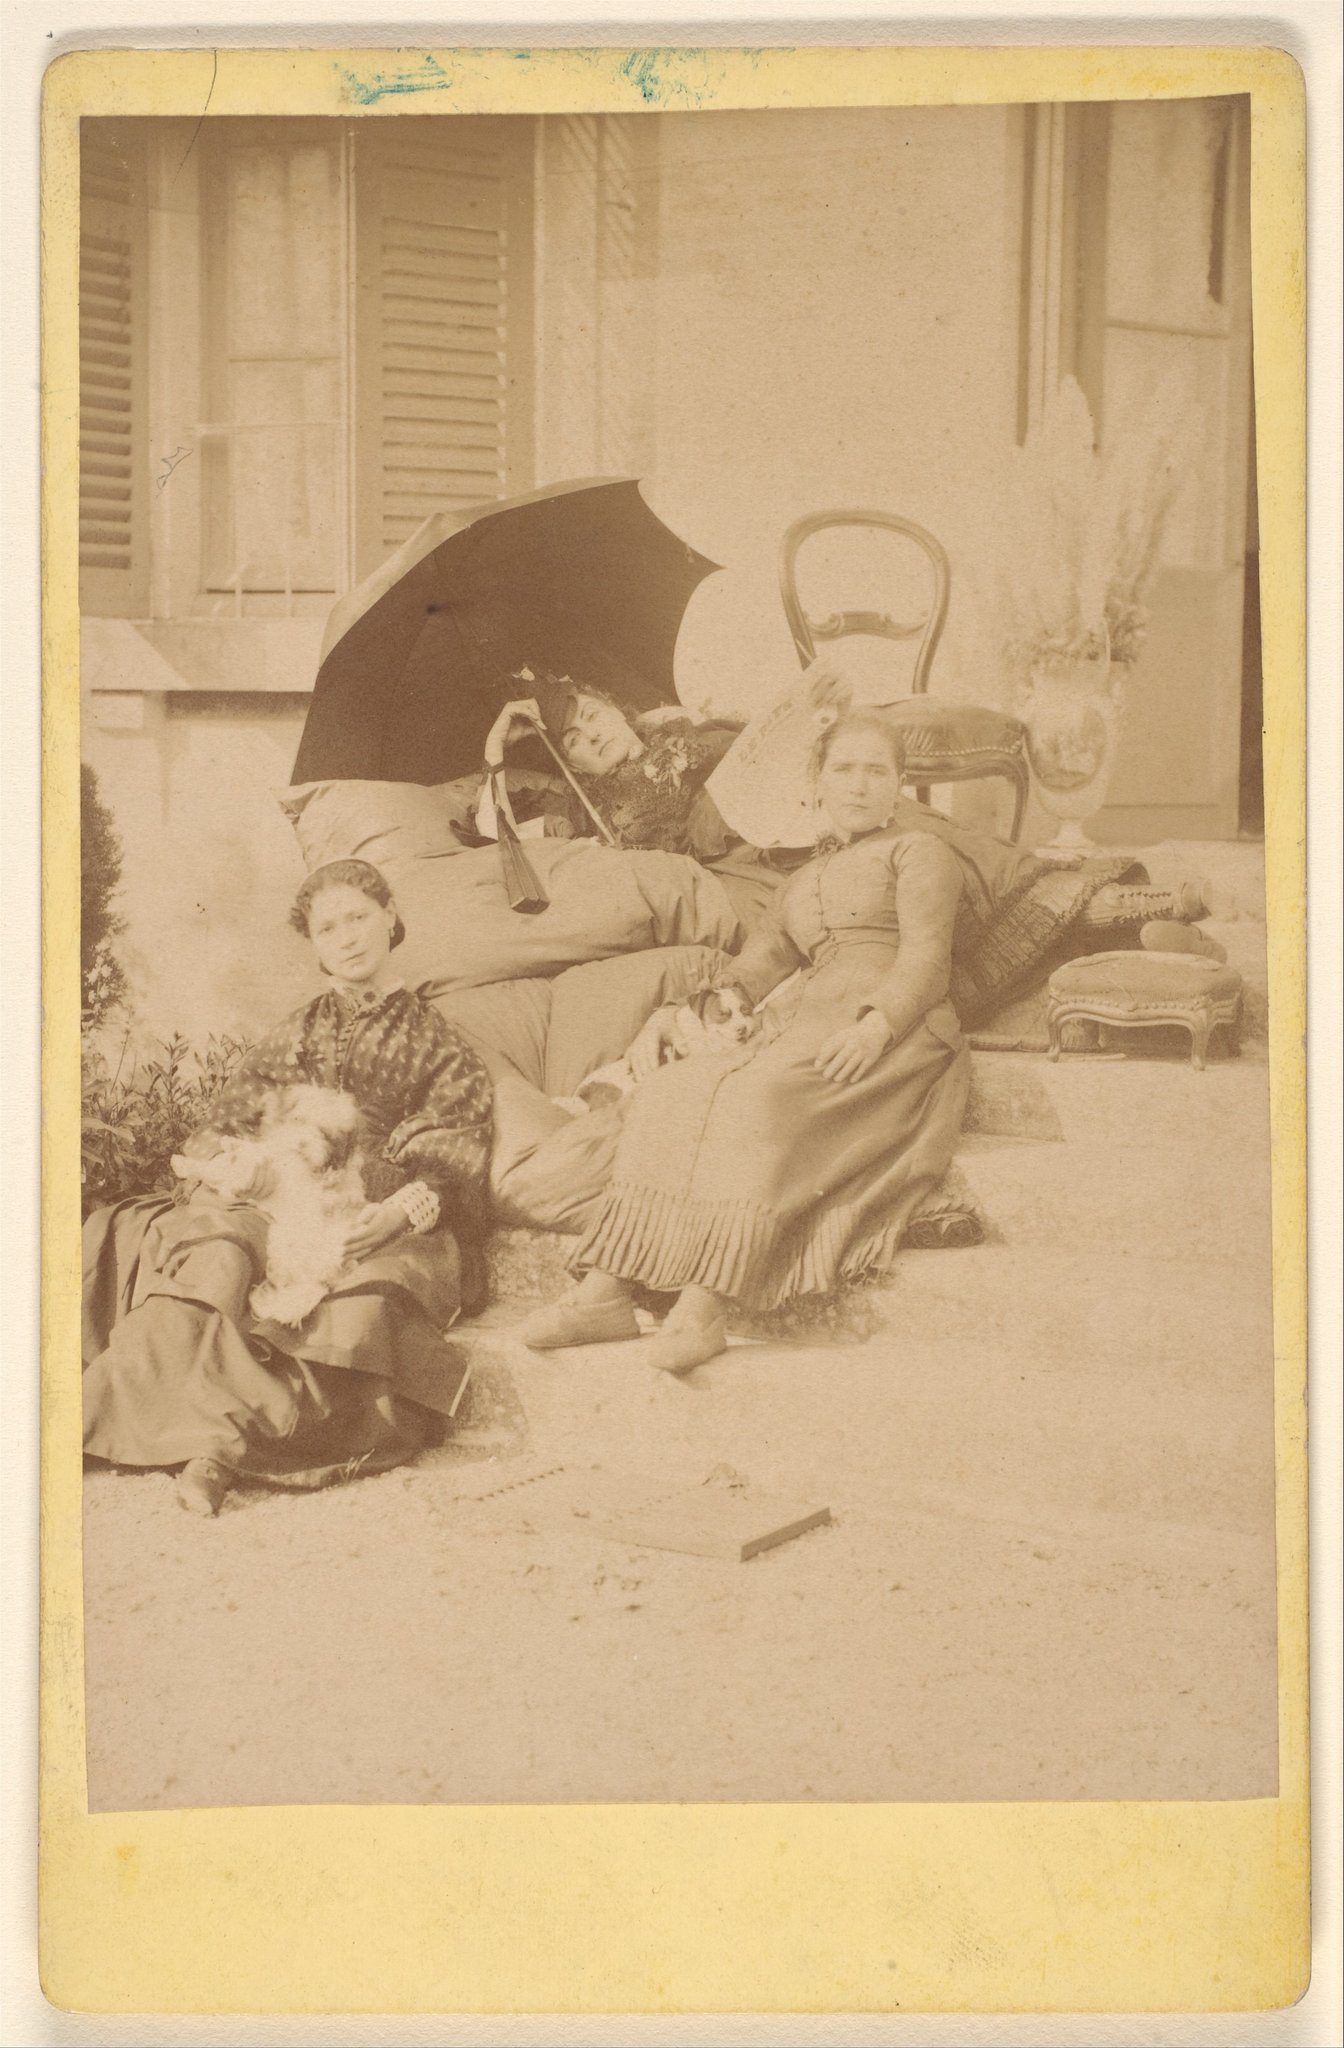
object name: photograph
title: Les Chiens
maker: pierre-louis pierson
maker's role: artist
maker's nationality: french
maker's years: 1822-1913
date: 1860-1869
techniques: albumen silver print, glass negative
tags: women,dogs